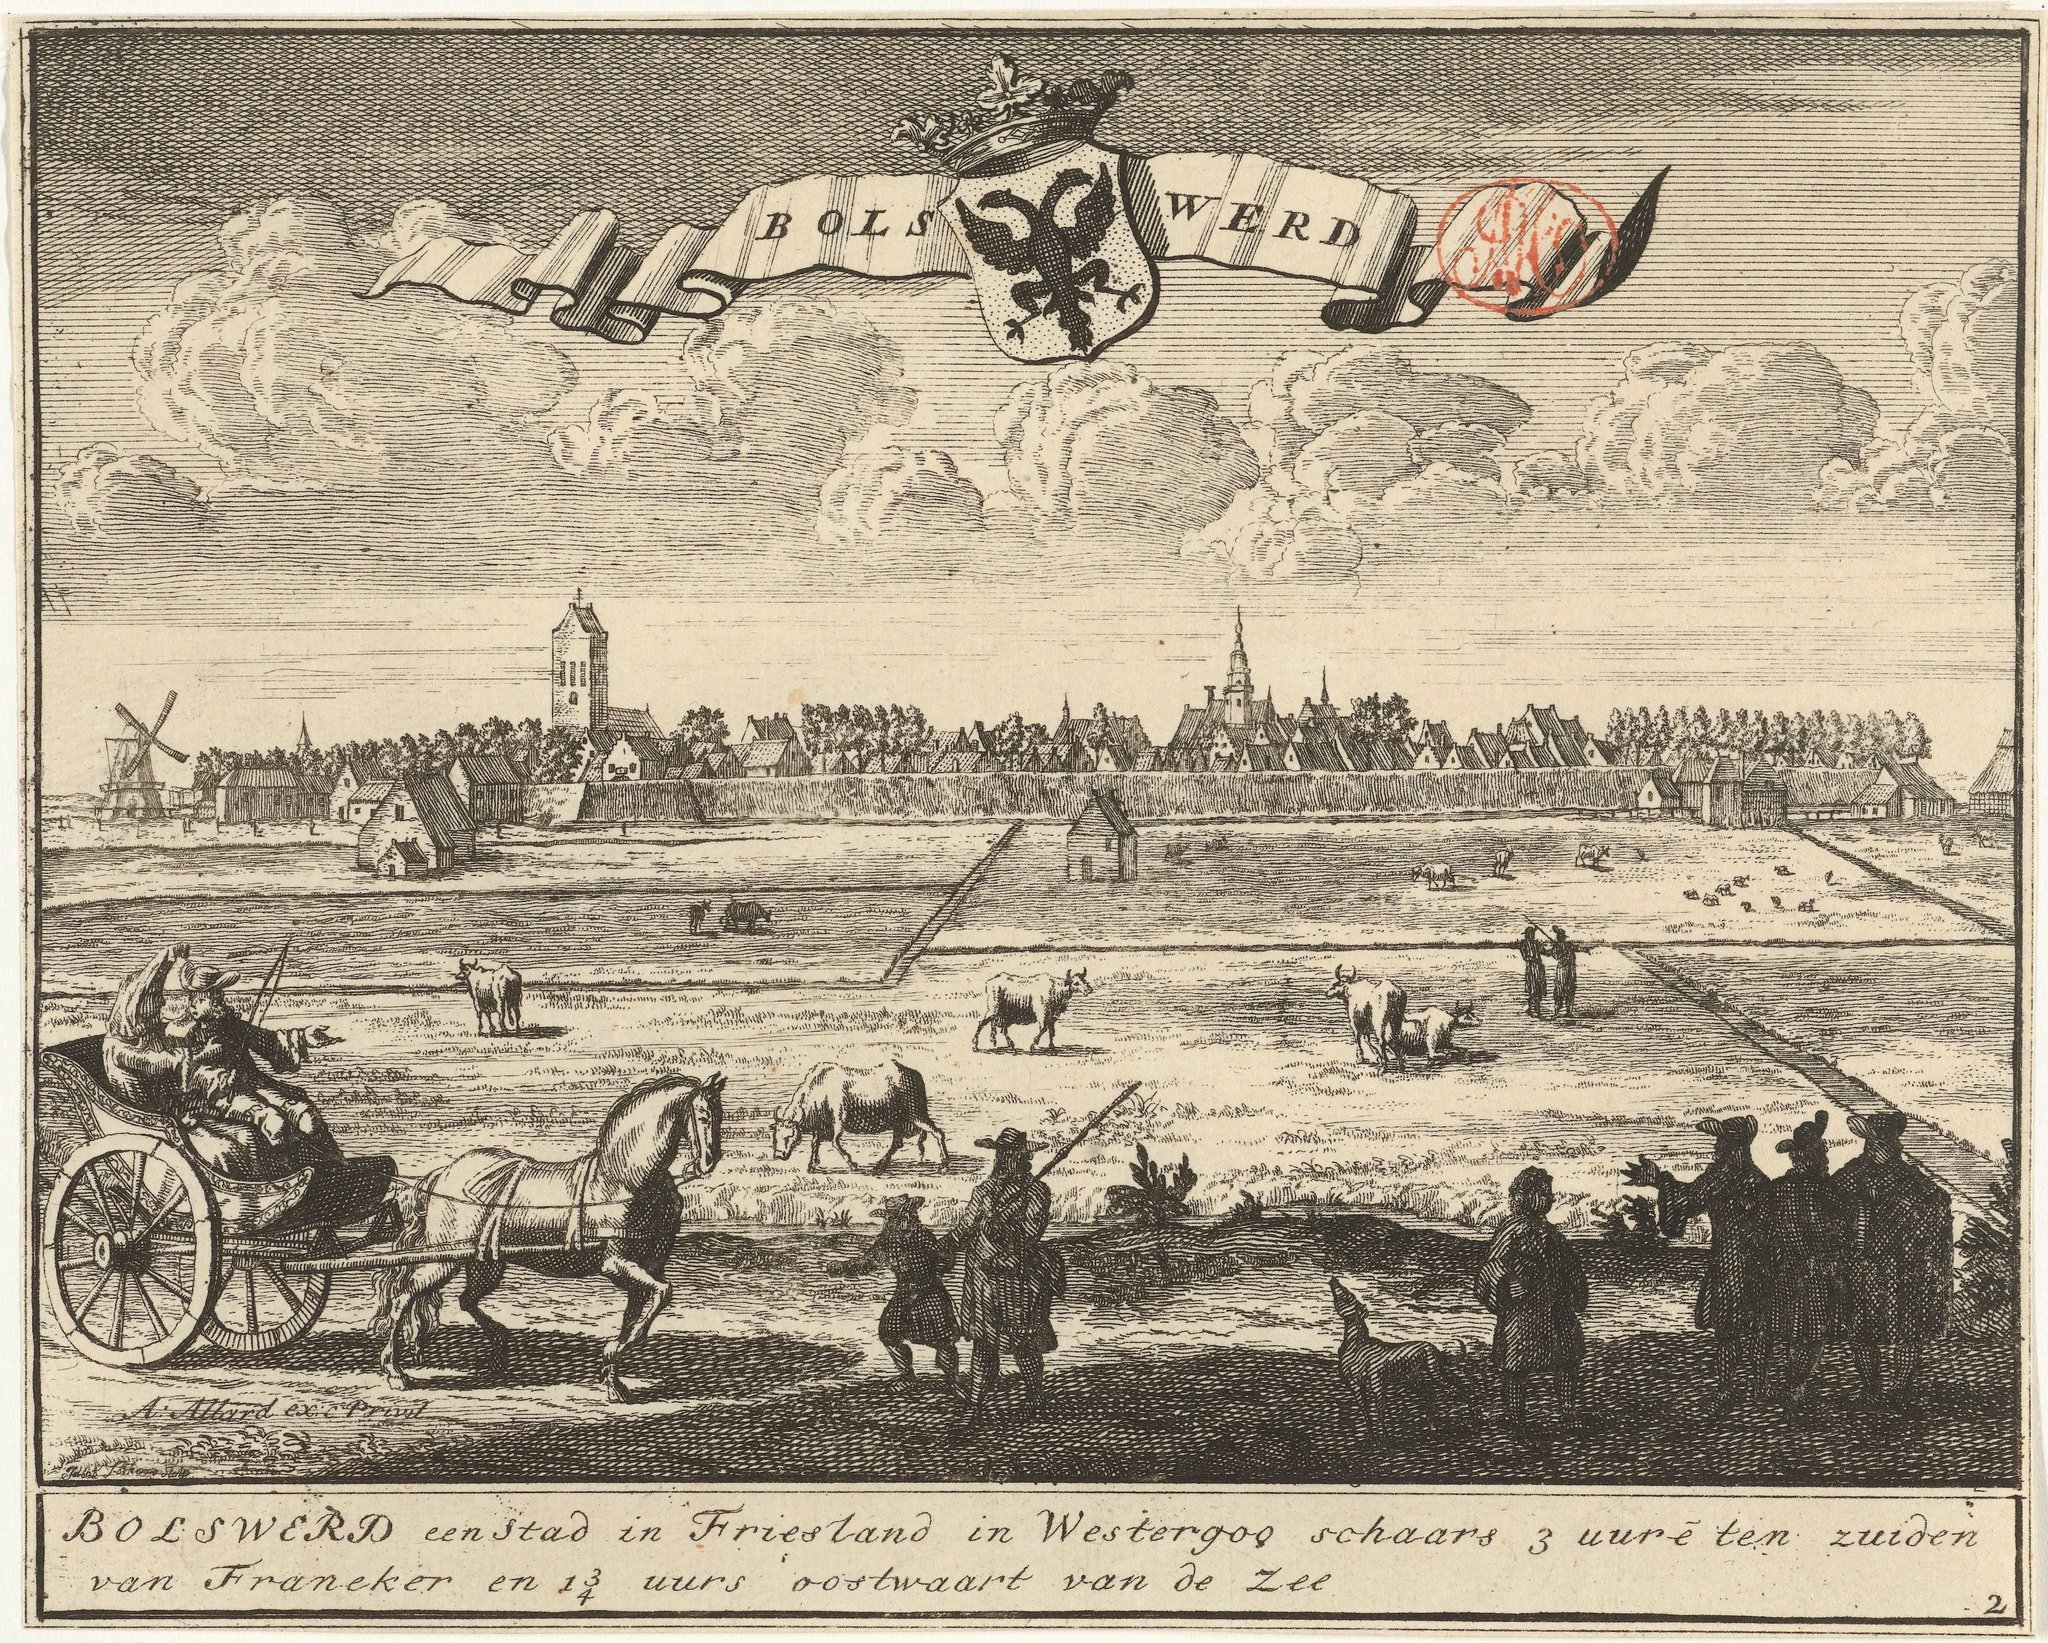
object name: print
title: Stadsgezichten uit Friesland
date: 1702-1725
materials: paper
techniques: etching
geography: amsterdam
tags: city-view, and landscape with man-made constructions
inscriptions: collector's mark: Lugt 2228, collector's mark: Lugt 195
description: Gezicht op de stad Bolsward waarboven een banderol met de naam en het wapen van de stad prijkt. In de marge staan twee regels tekst in het Nederlands, geheel rechtsonder gemerkt: 2. De prent maakt deel uit van een serie prenten met stadsgezichten op diverse steden in Friesland.